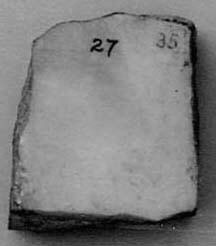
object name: fragment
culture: burmese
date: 1902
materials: jade